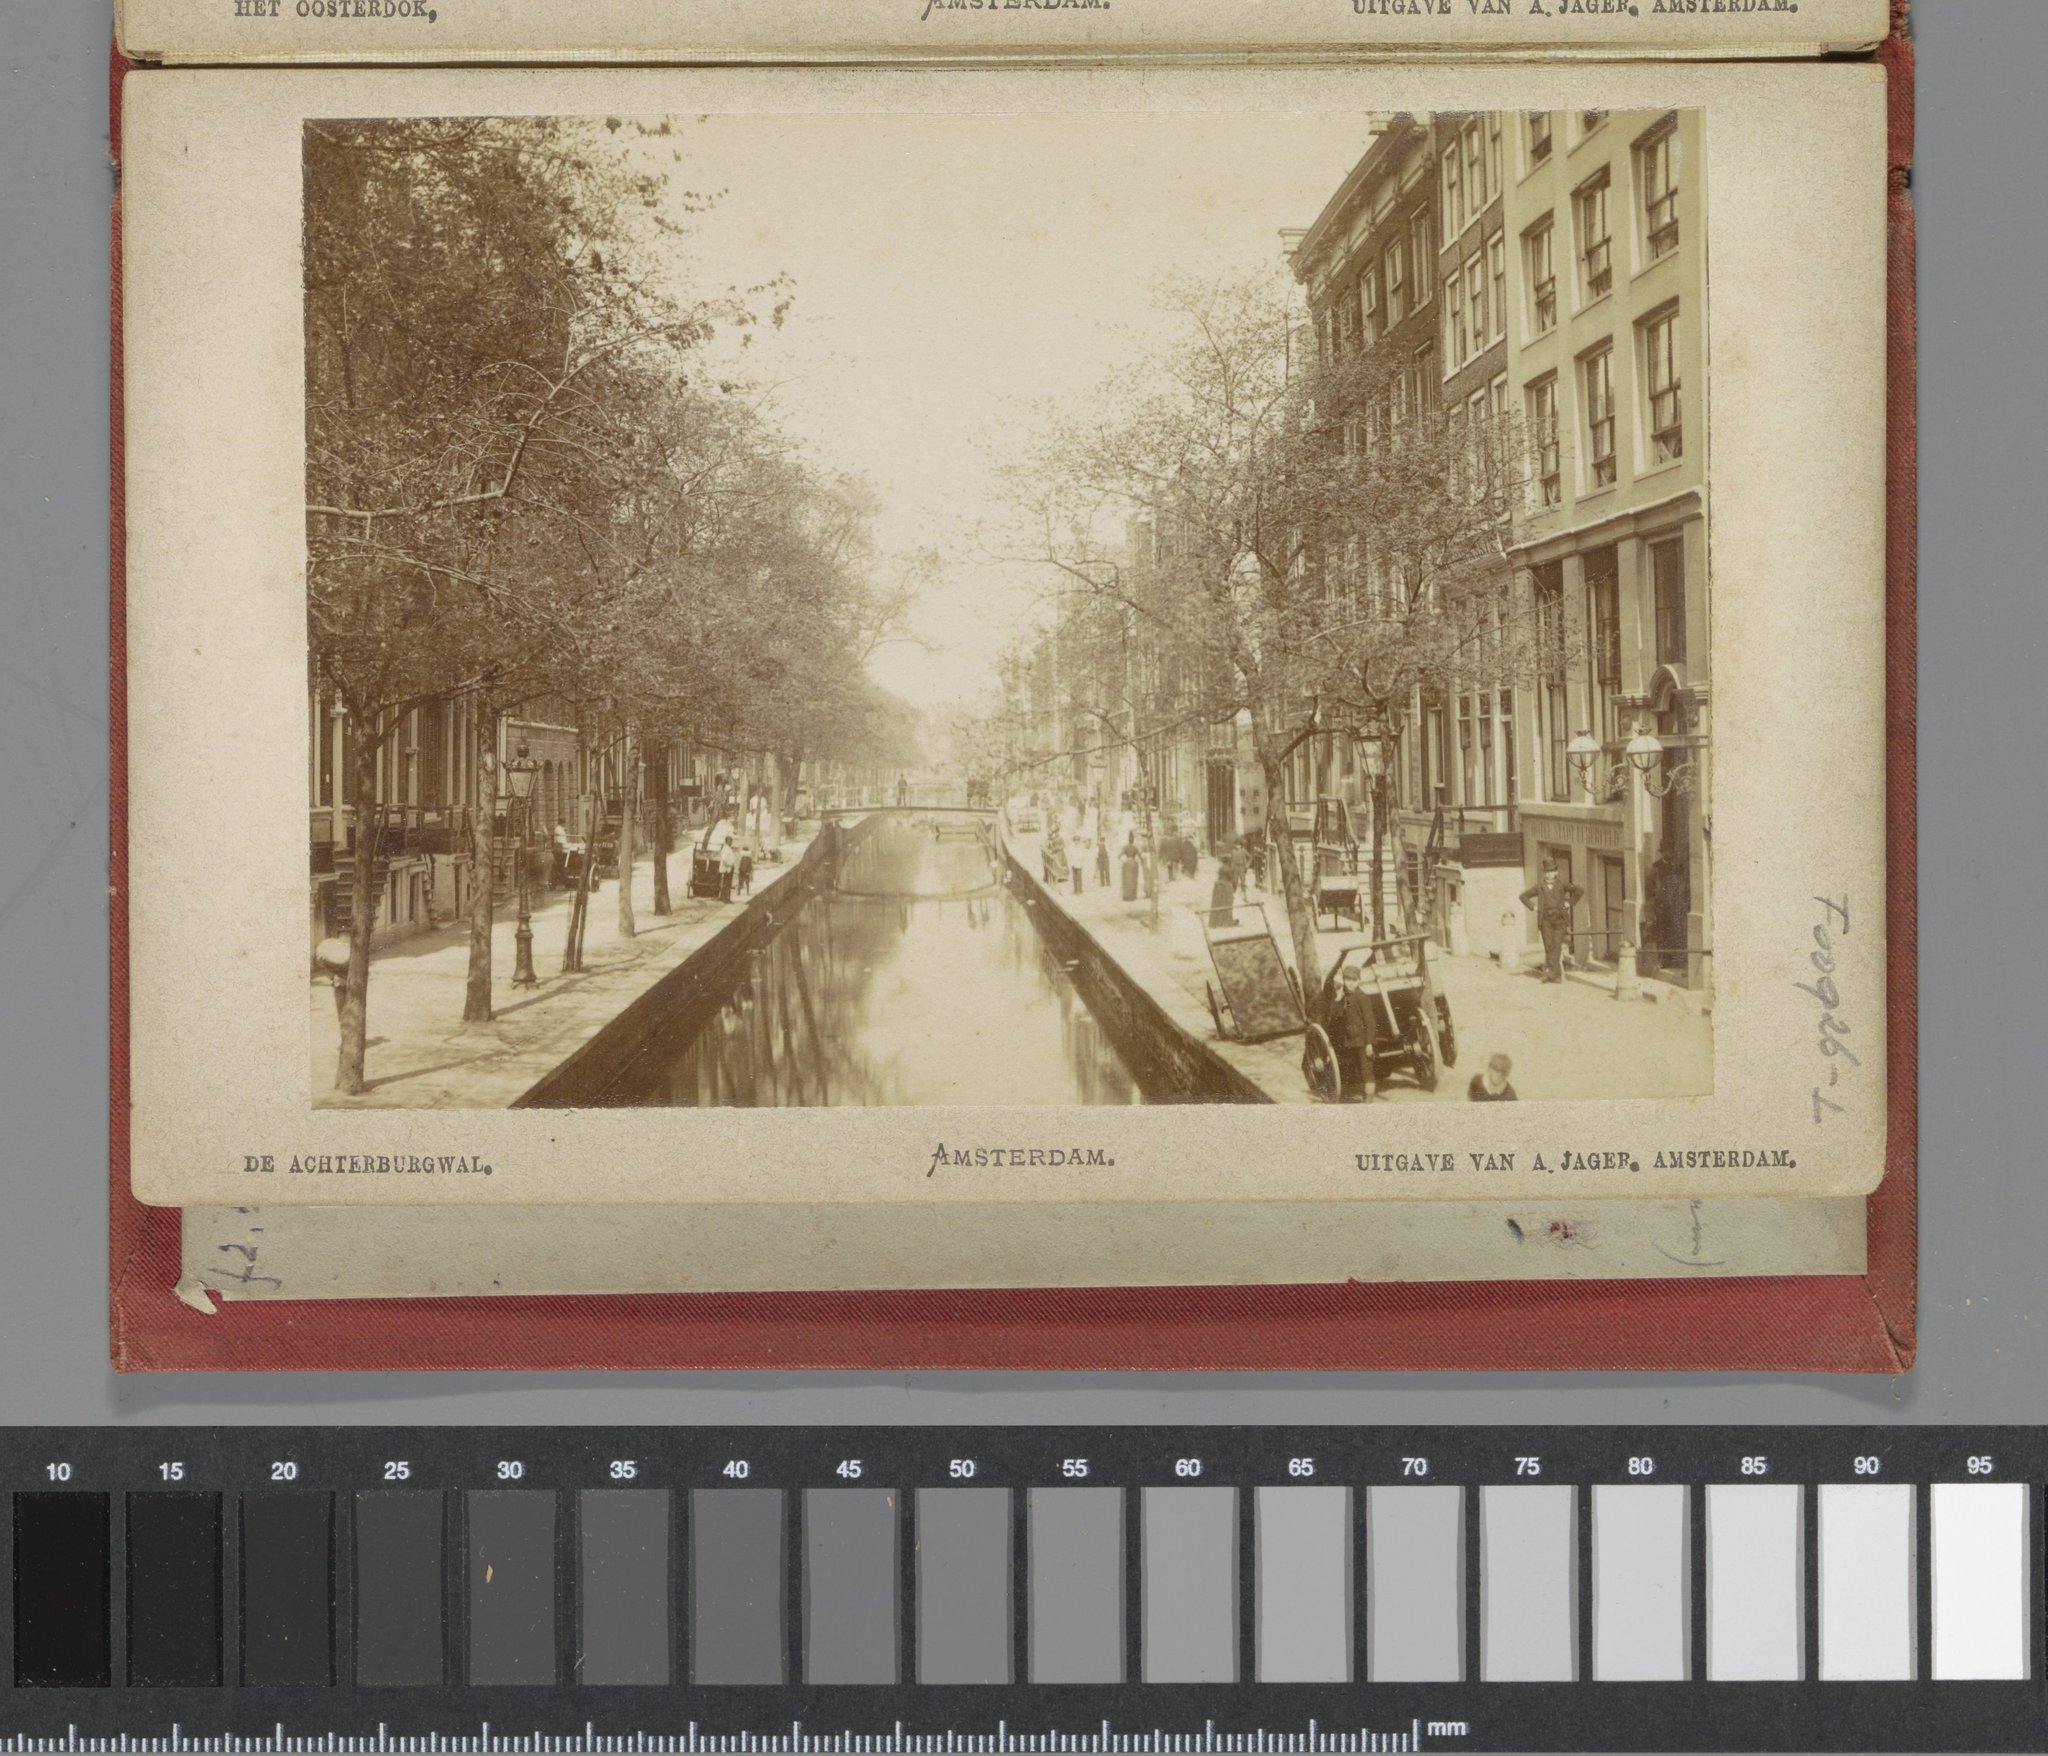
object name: cabinet photograph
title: De Achterburgwal. Amsterdam.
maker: andries jager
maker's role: publisher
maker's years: 1825-1905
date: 1860-1900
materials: cardboard, photographic support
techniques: albumen print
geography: amsterdam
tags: canal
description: Onderdeel van Leporelloalbum met 12 foto's van Amsterdam.